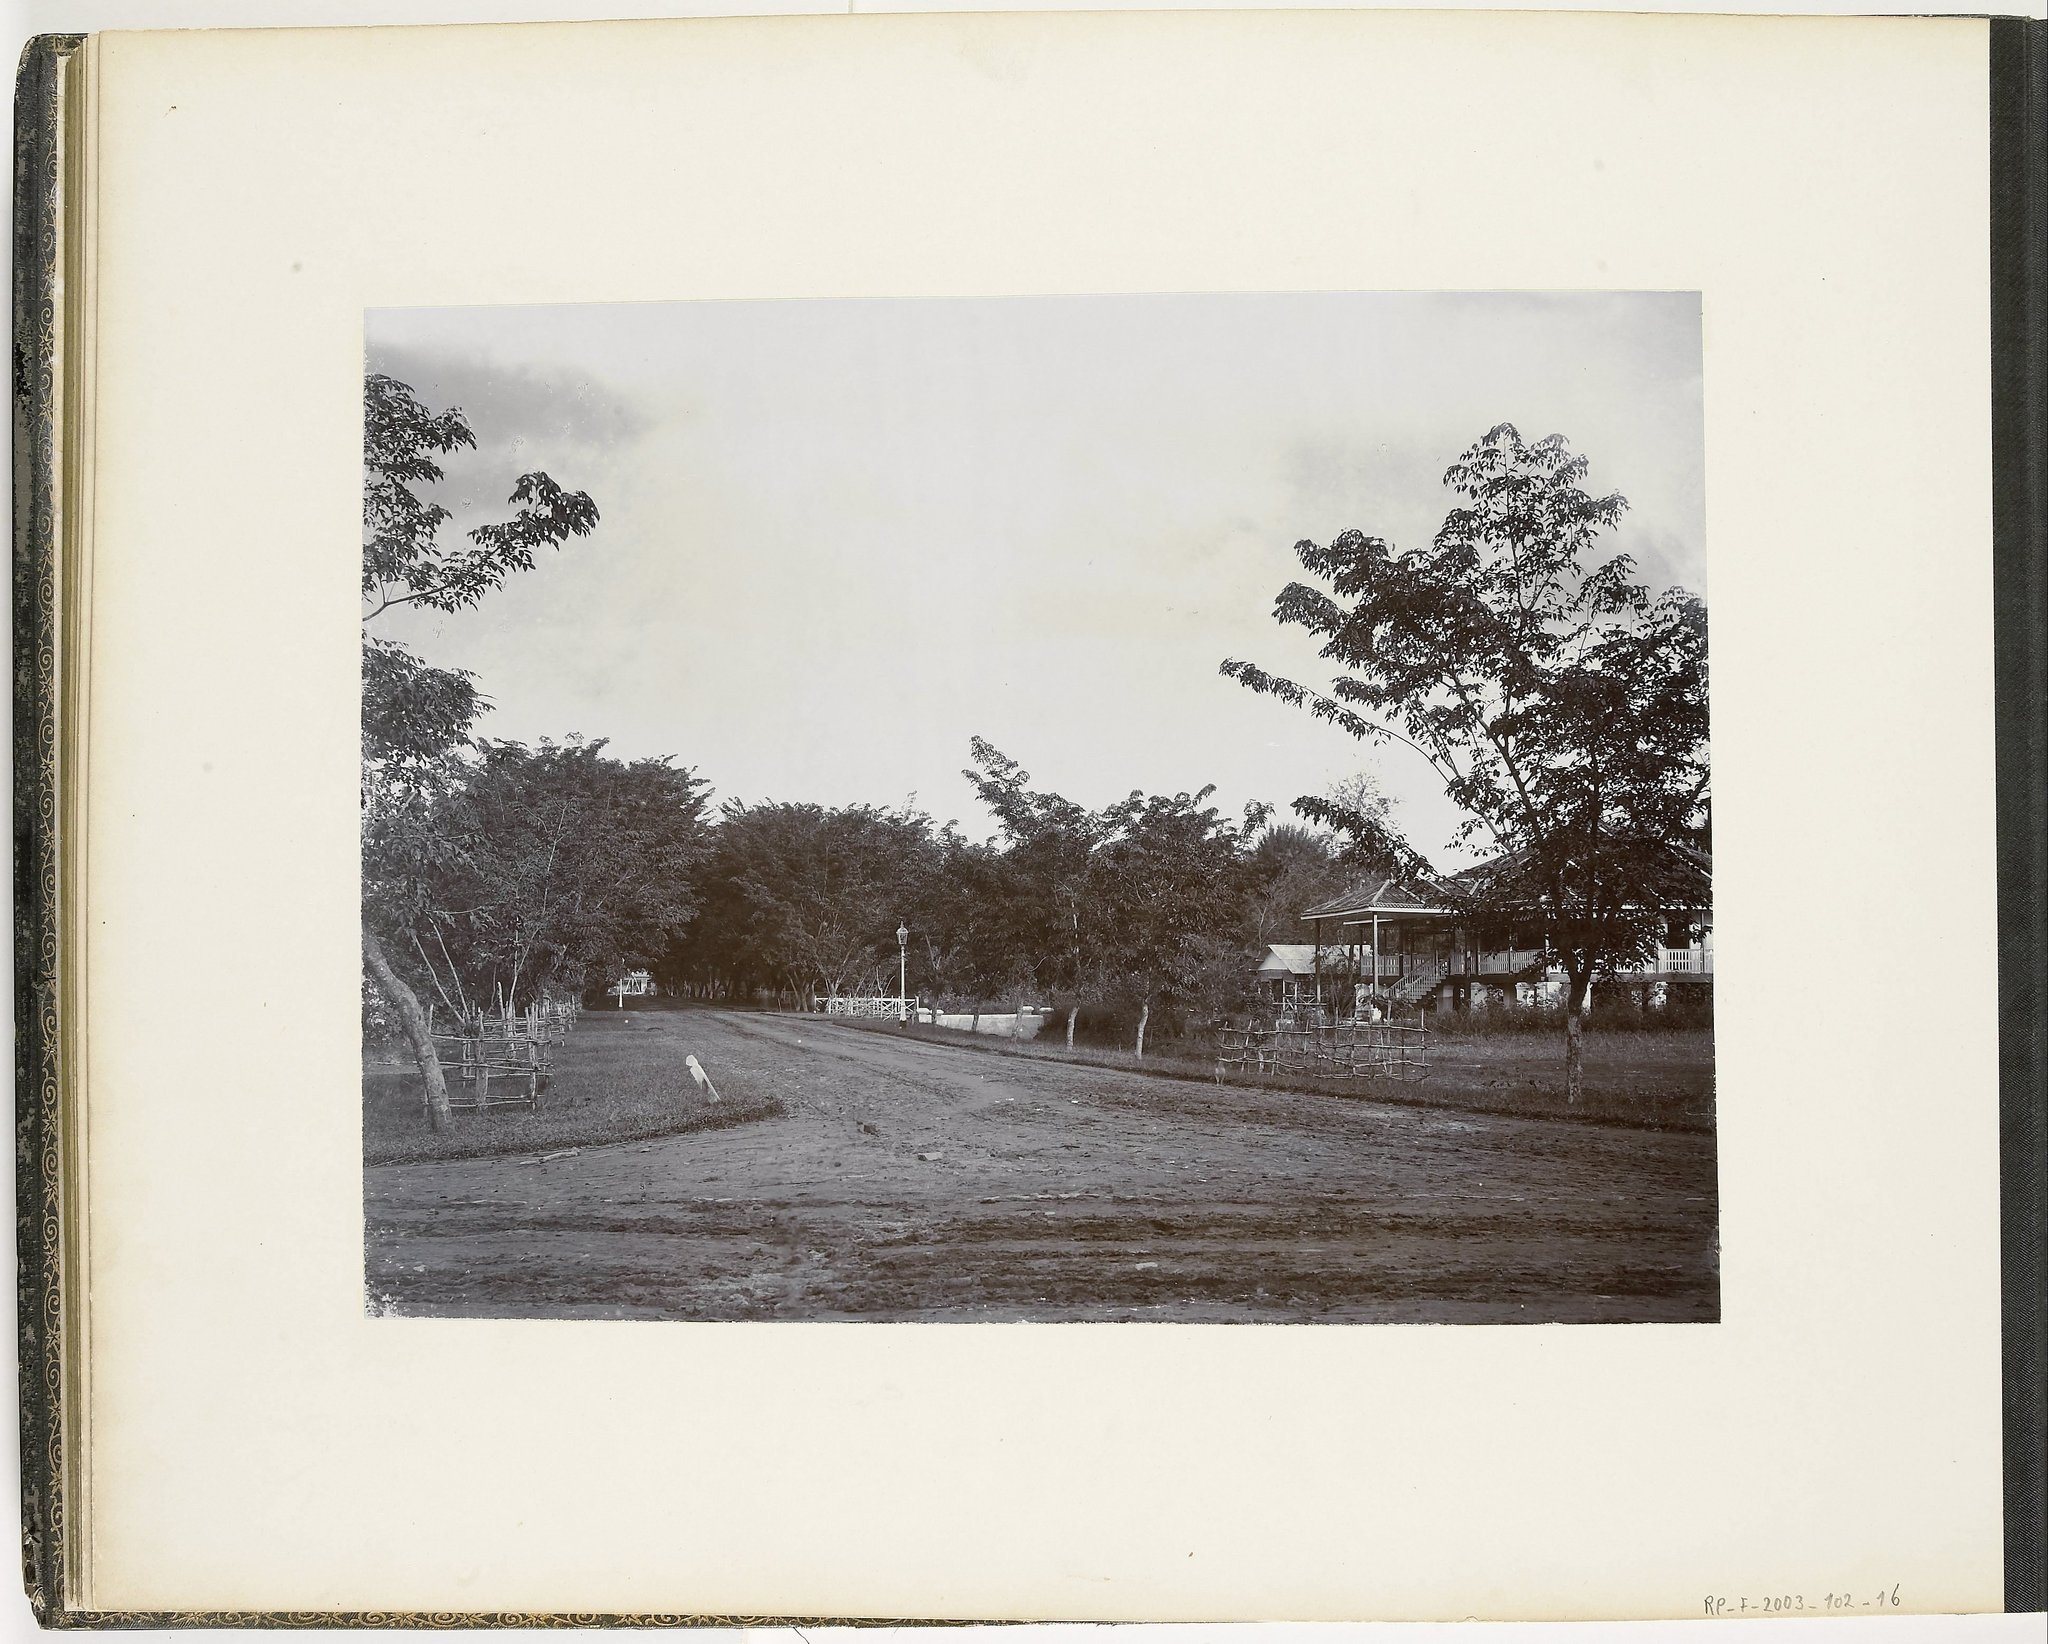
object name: photograph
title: Gezicht op Sennah Allee, Tandjong Poera, Sumatra (Sennah Allee Tandjong Poera)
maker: carl j. kleingrothe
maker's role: fotograaf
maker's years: 1864-1925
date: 1885-1900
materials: photographic support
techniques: collodion silver print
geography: tandjong poera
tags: tandjong poera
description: Gezicht op de Sennah-Allee in Tandjoengpoera (Tandjong Poera) op de Oostkust van Sumatra. Rechts van de laan een woonhuis. Onderdeel van het Sumatra fotoalbum van Paul en Lucie Sandel uit 1900.